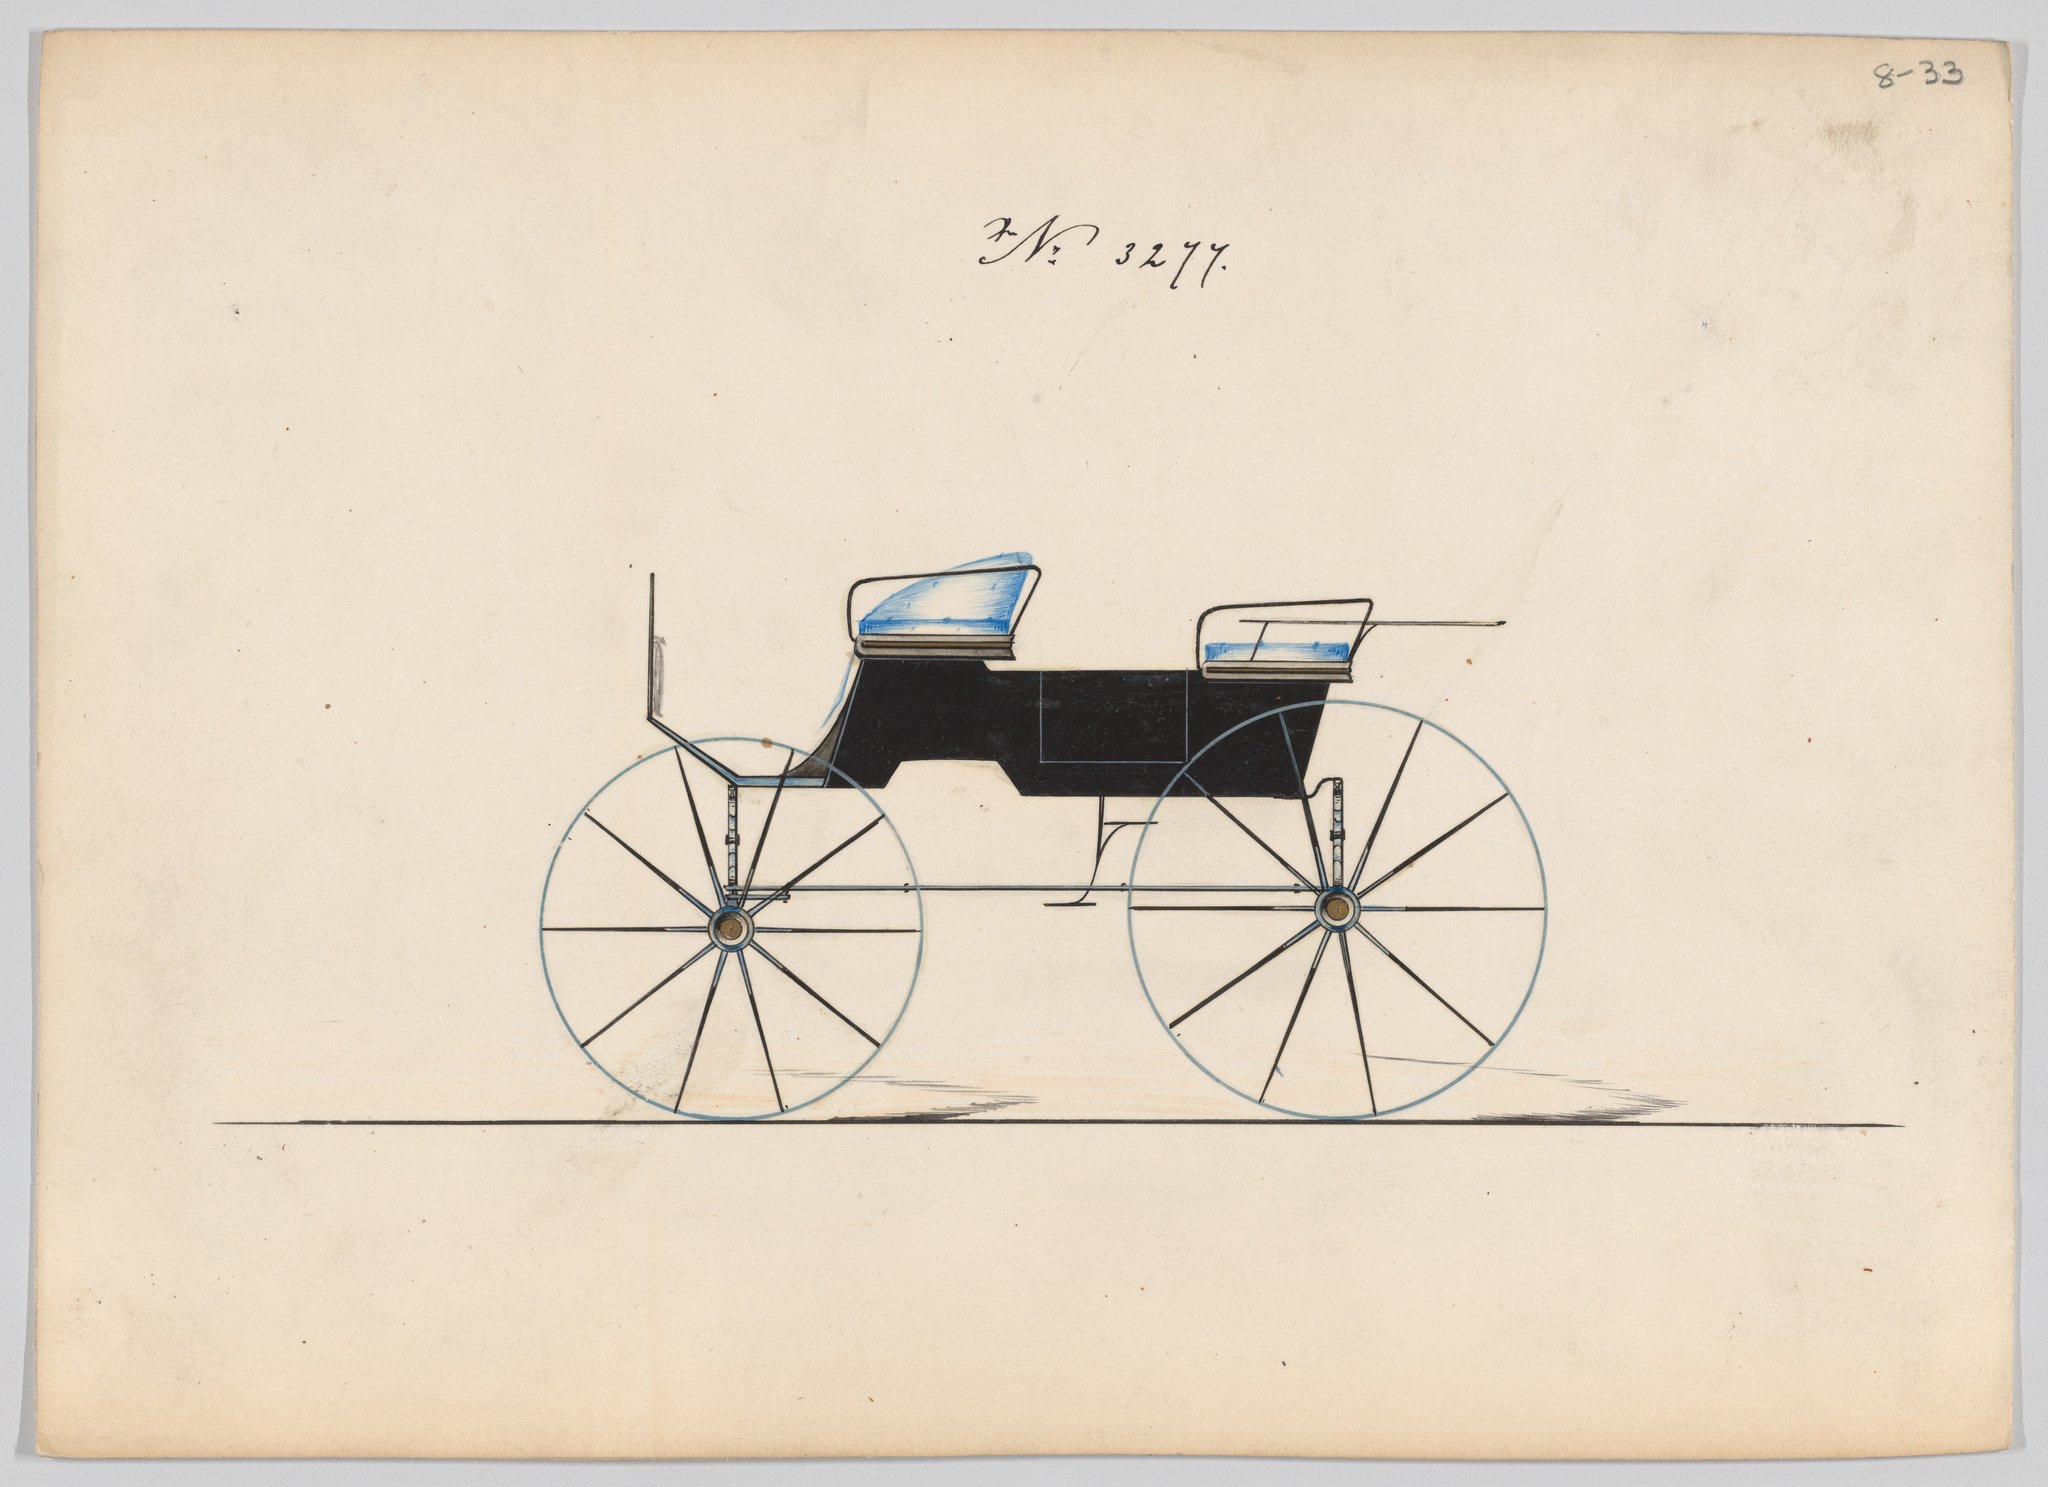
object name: drawing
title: Design for 4 seat Phaeton, no top, no. 3277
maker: brewster & co.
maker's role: manufacturer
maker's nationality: american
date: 1876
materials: gouache, gum arabic, ink, watercolor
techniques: pen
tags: carriages